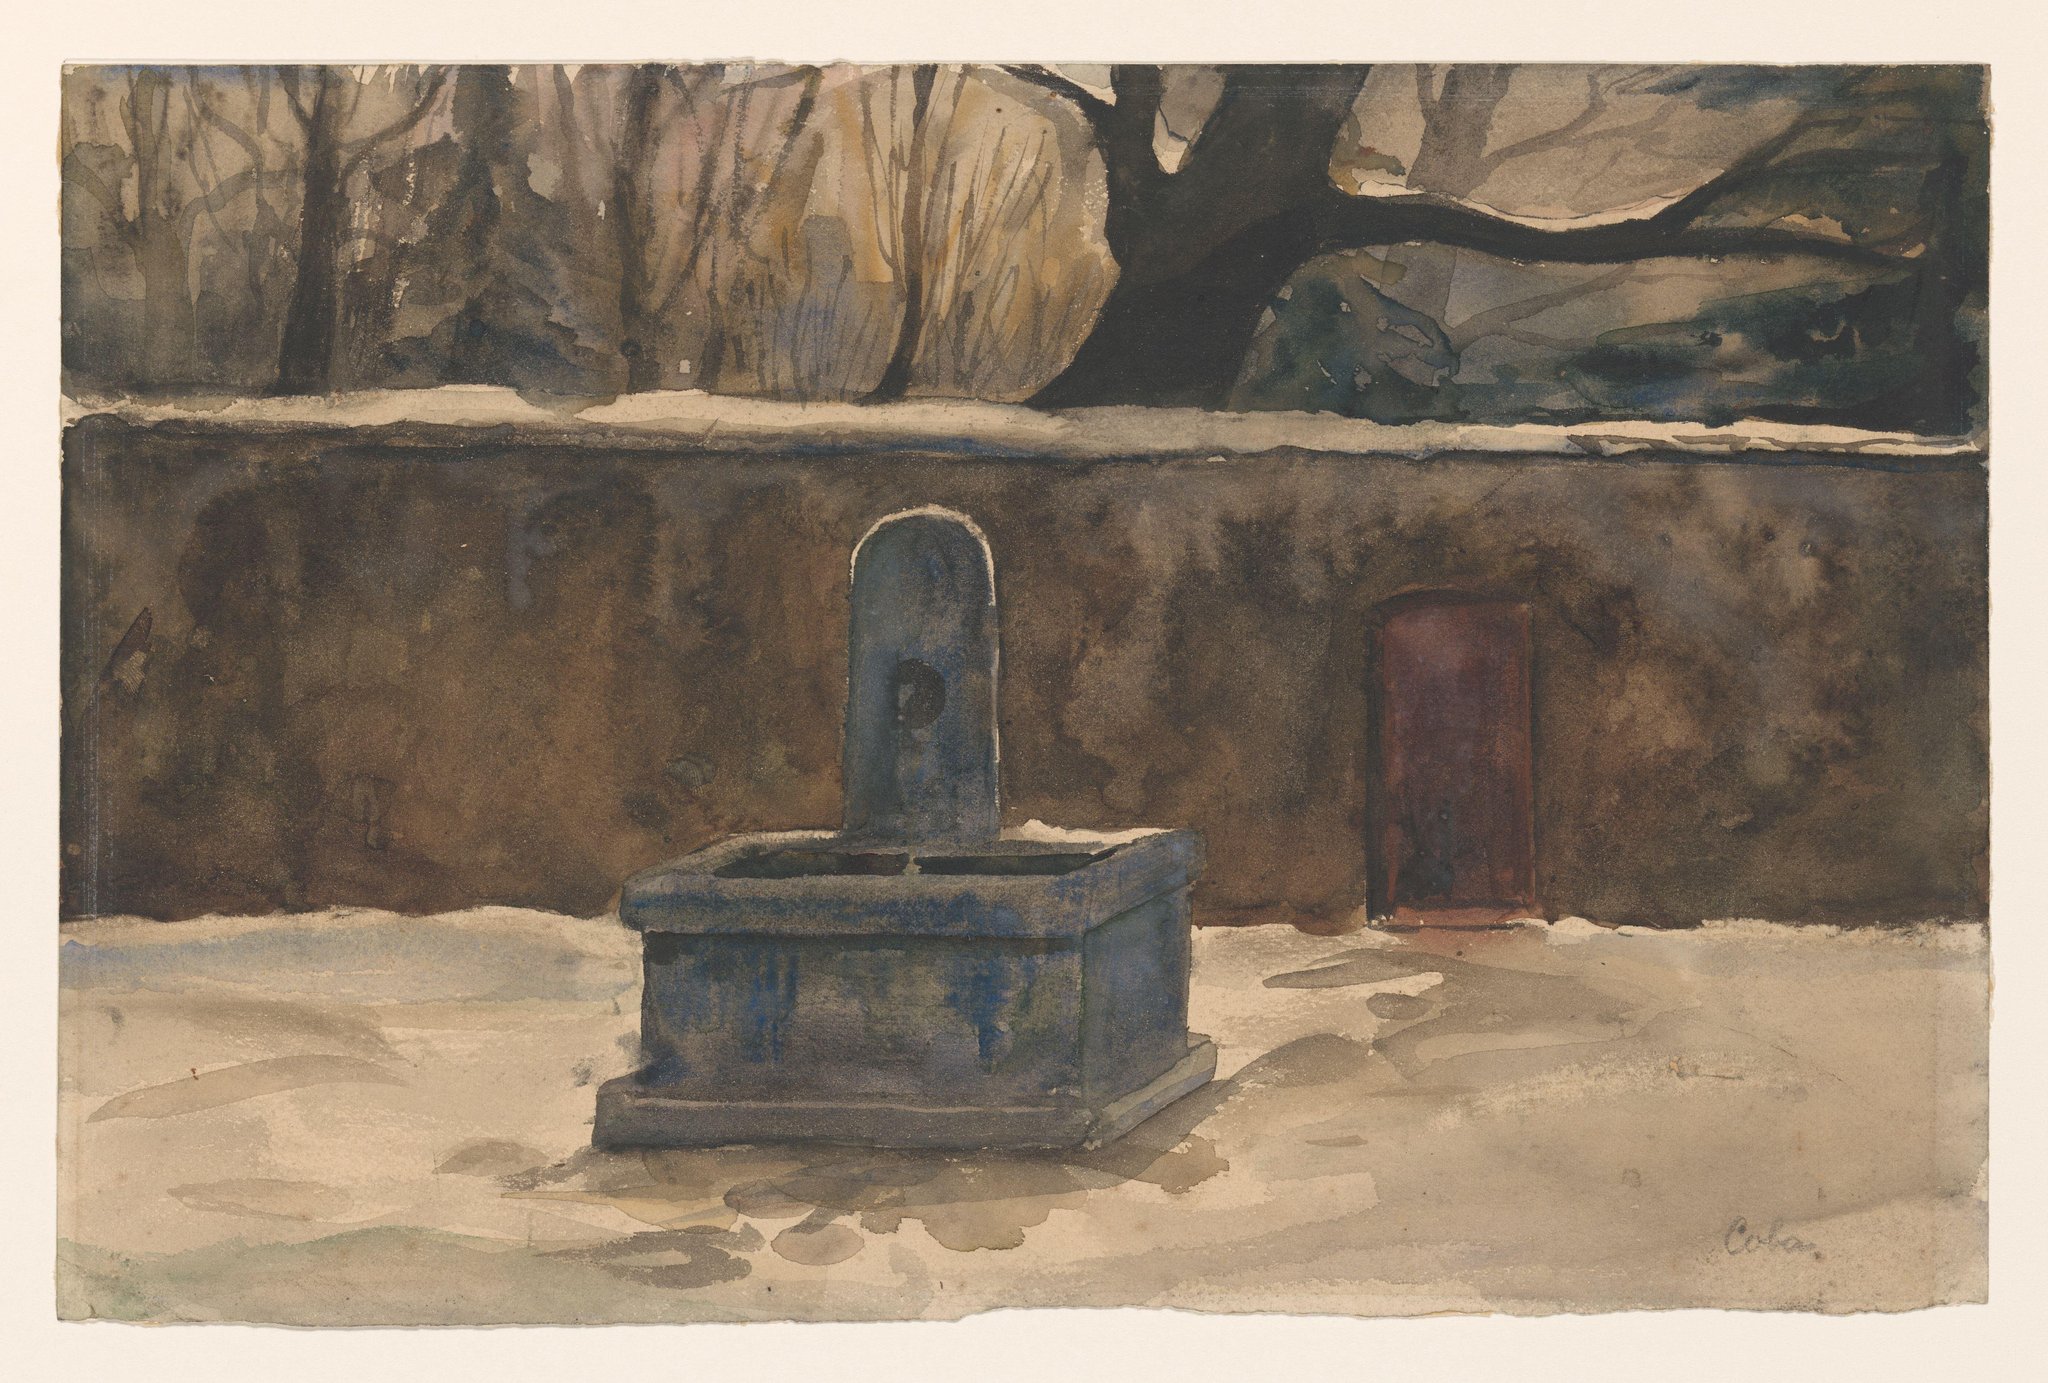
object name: watercolor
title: Waterput bij muur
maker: coba steenhoff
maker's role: draughtsman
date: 1800-1900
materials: paper, watercolor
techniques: brush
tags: well